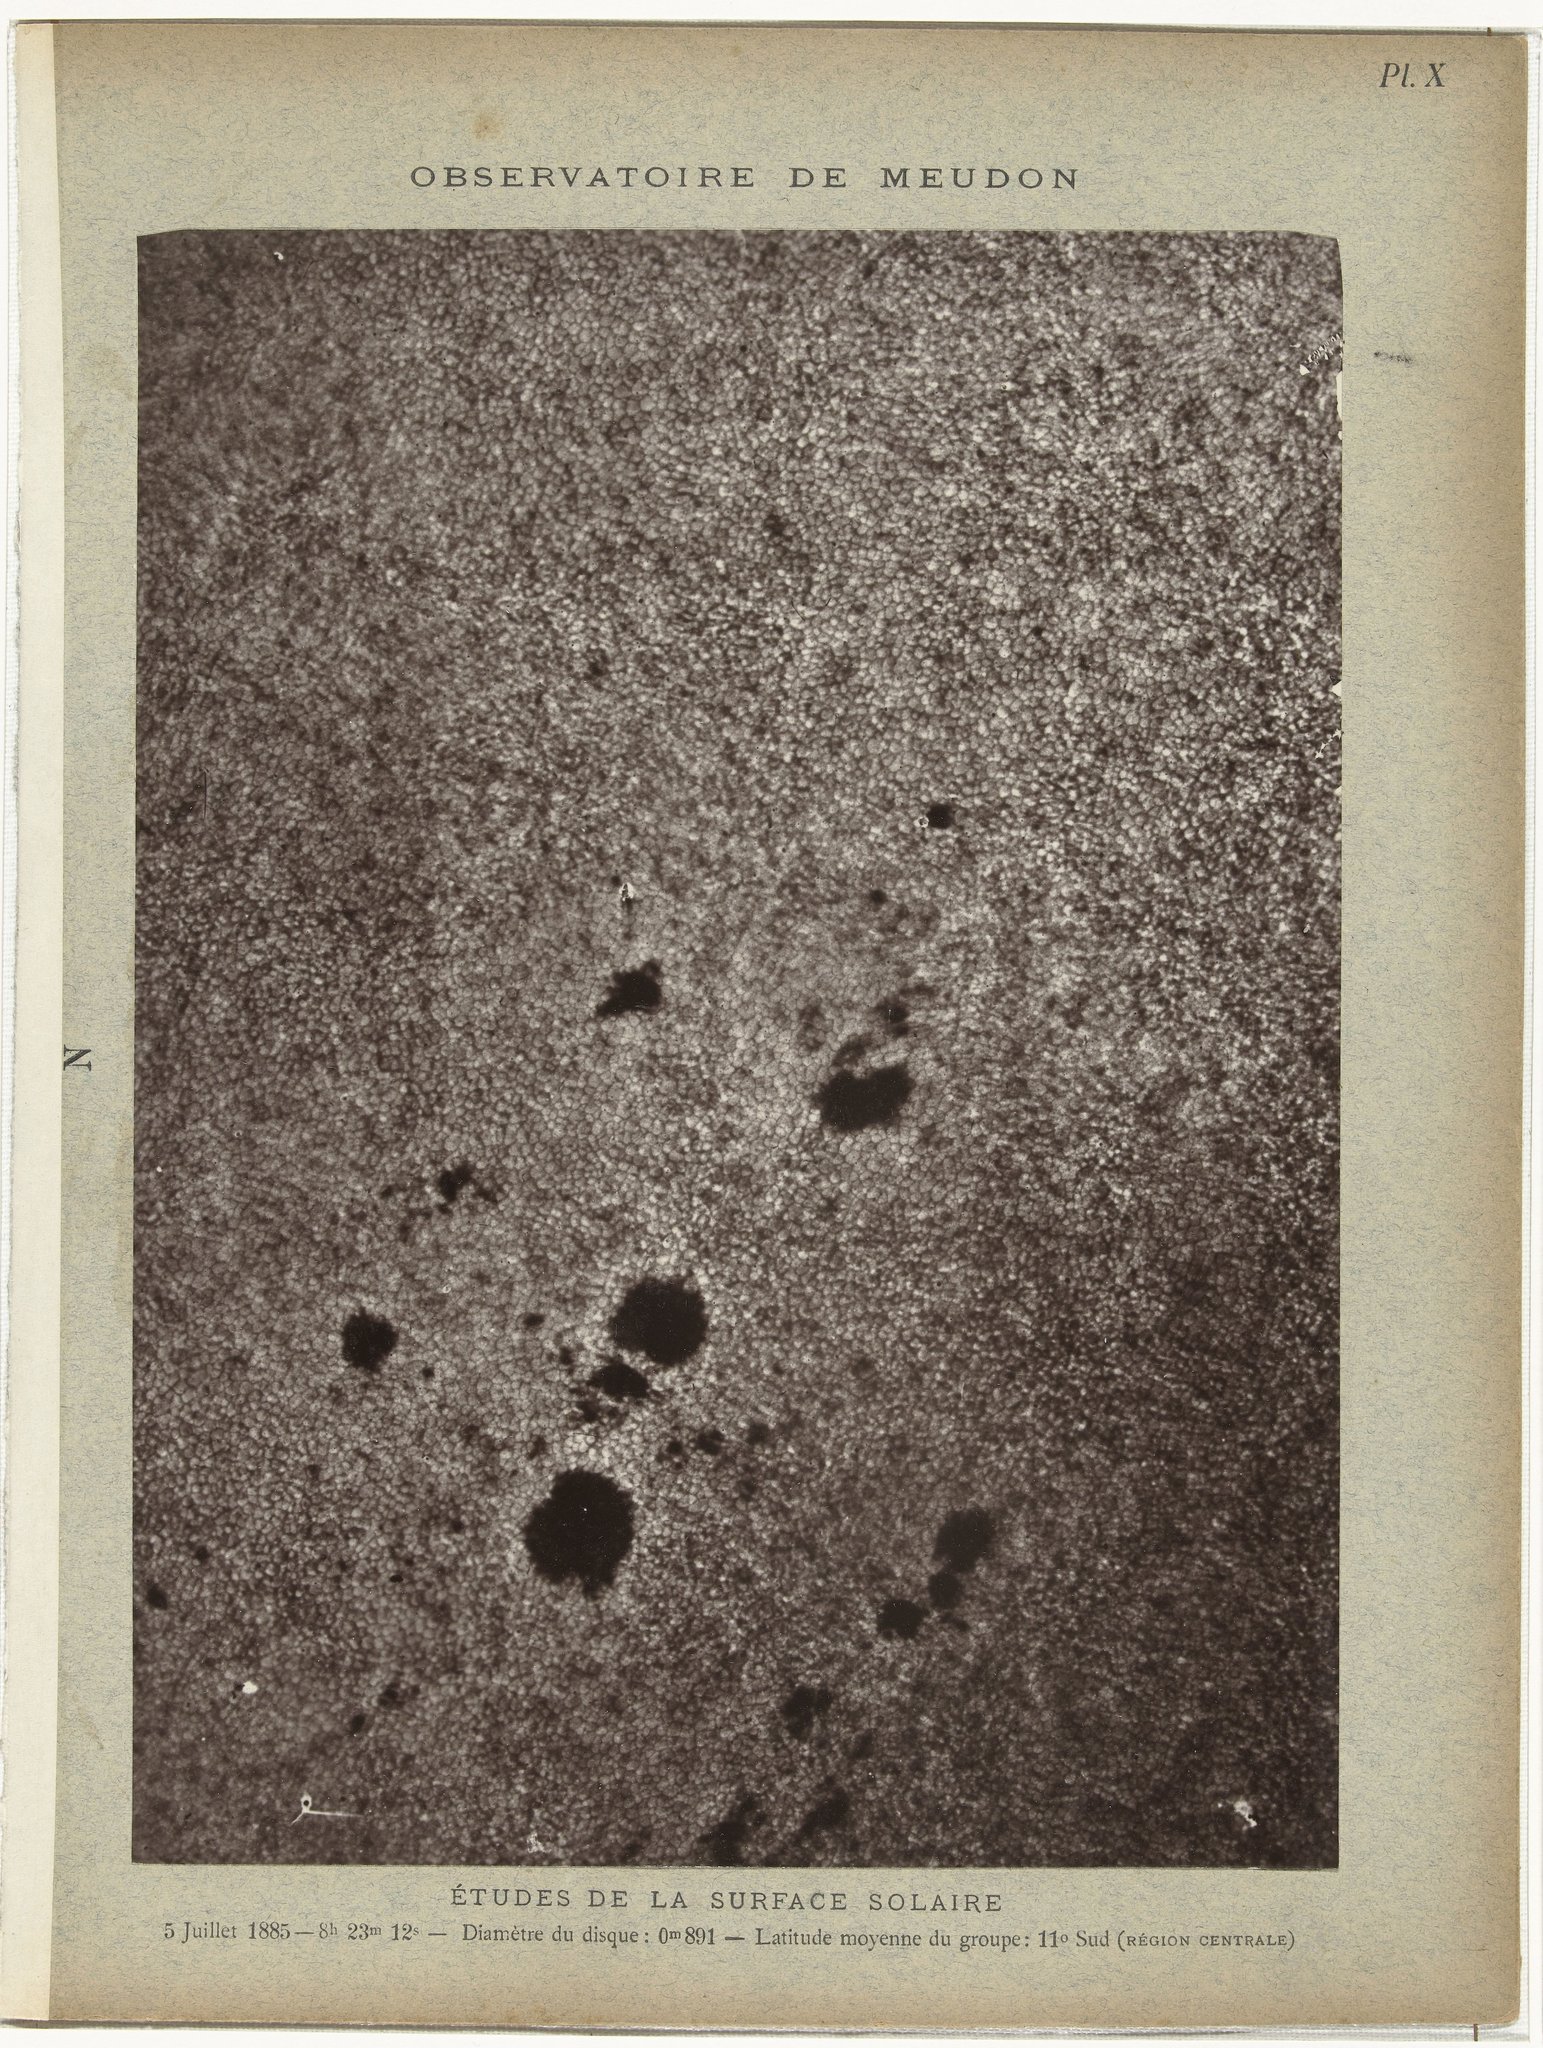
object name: photograph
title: Oppervlakte van de zon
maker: pierre jules césar janssen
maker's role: astronoom, fotograaf, uitvinder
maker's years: 1824-1907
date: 1885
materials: cardboard, paper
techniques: carbon print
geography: meudon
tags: sun-spots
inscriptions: inscription: ‘Pl. X/ Observatoire de Meudon/ Études de la Surface Solaire/ 5 Juillet 1885 - 8h 23m 12s - Diamètre du disque: 0m891 - Latitude moyenne du groupe: 11o Sud (Région Centrale)’